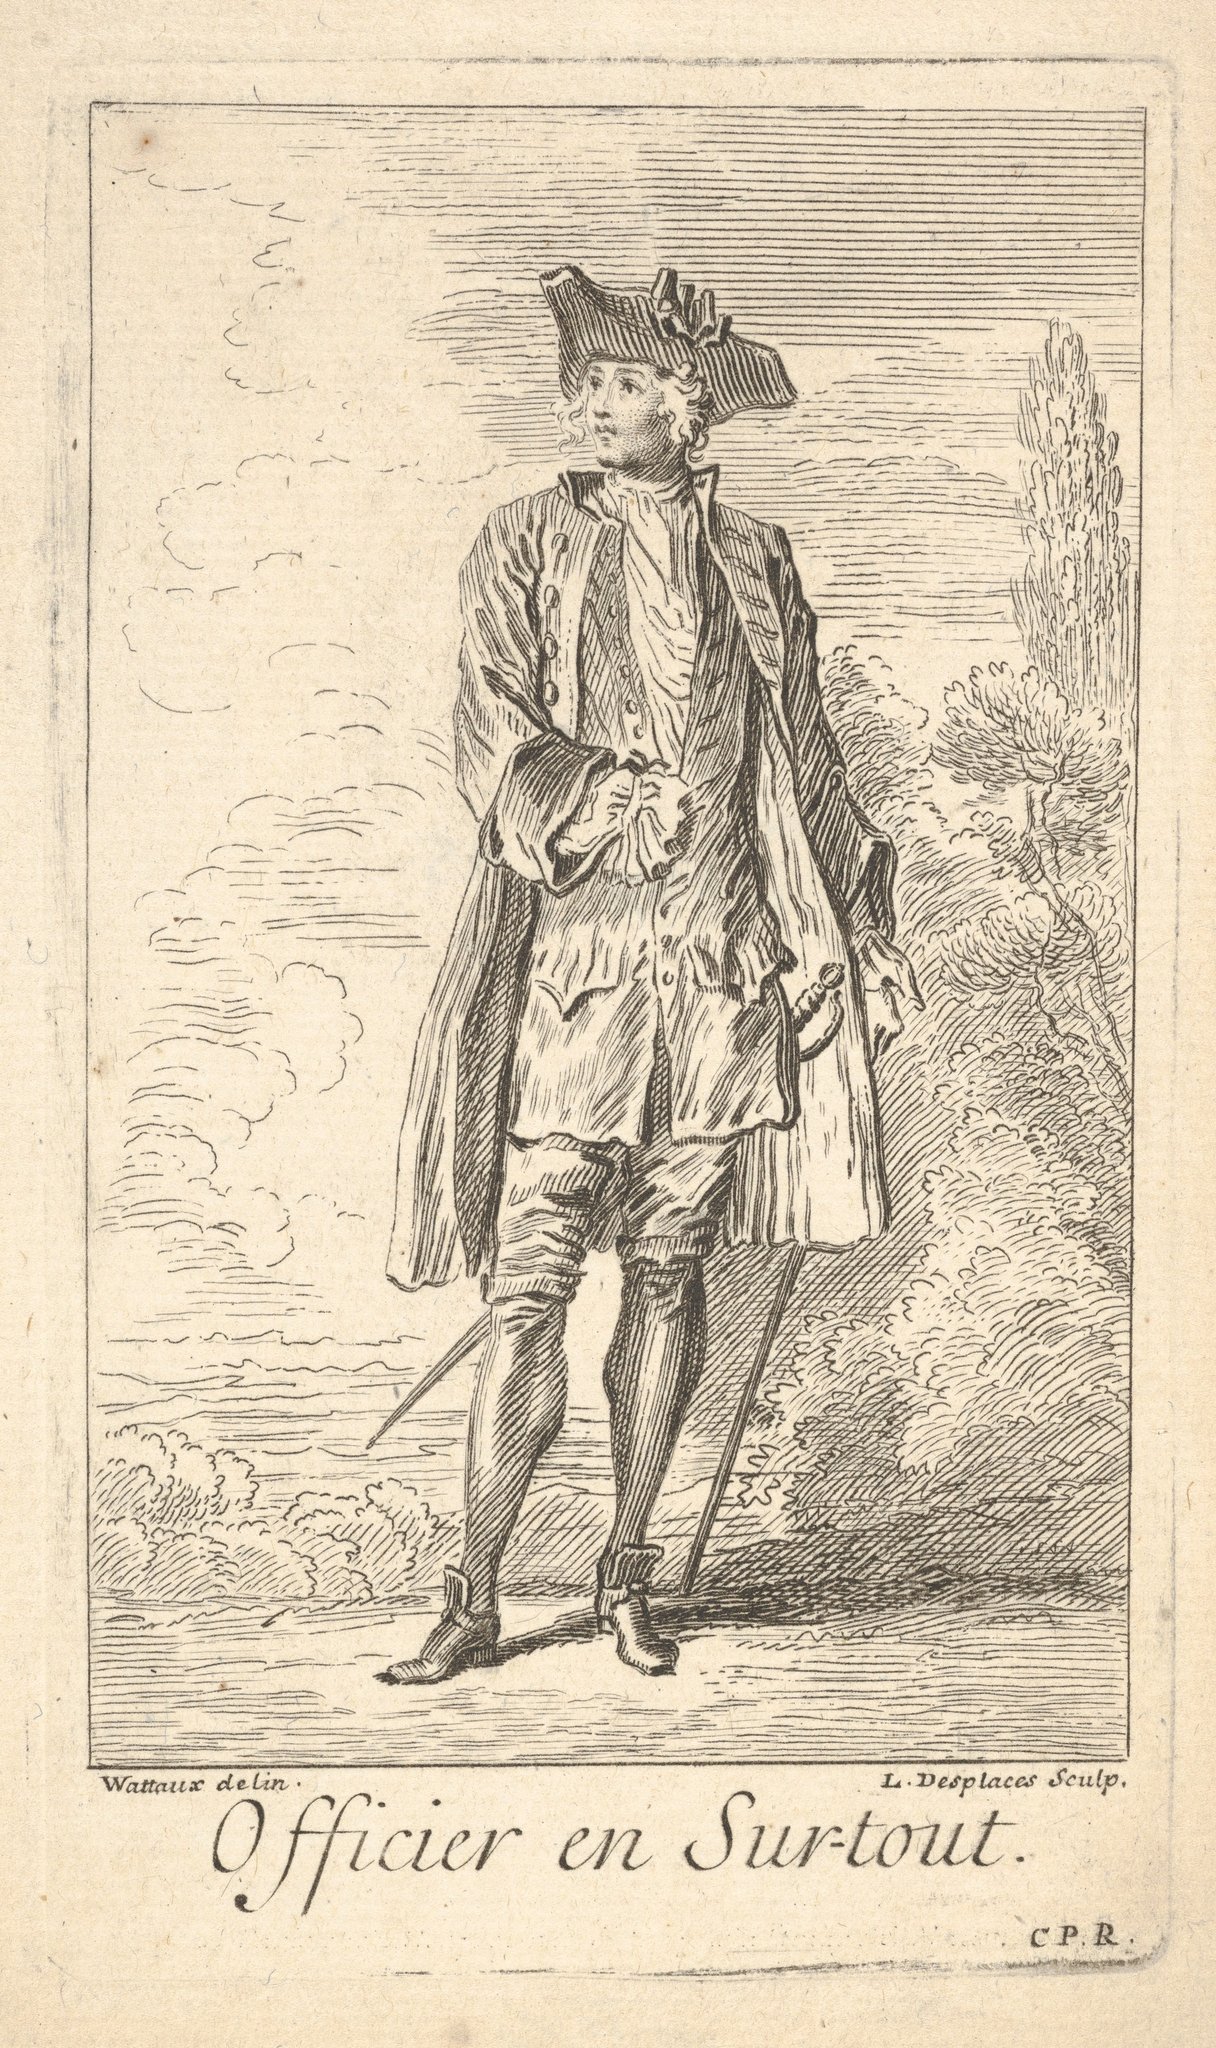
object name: print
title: Man in officer's dress, with sword hanging at left hip, shown in frontal view with his head turned toward the left, trees beyond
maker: louis desplaces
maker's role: artist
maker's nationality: french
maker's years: 1682-1739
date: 1700-1739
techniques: engraving, etching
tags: men